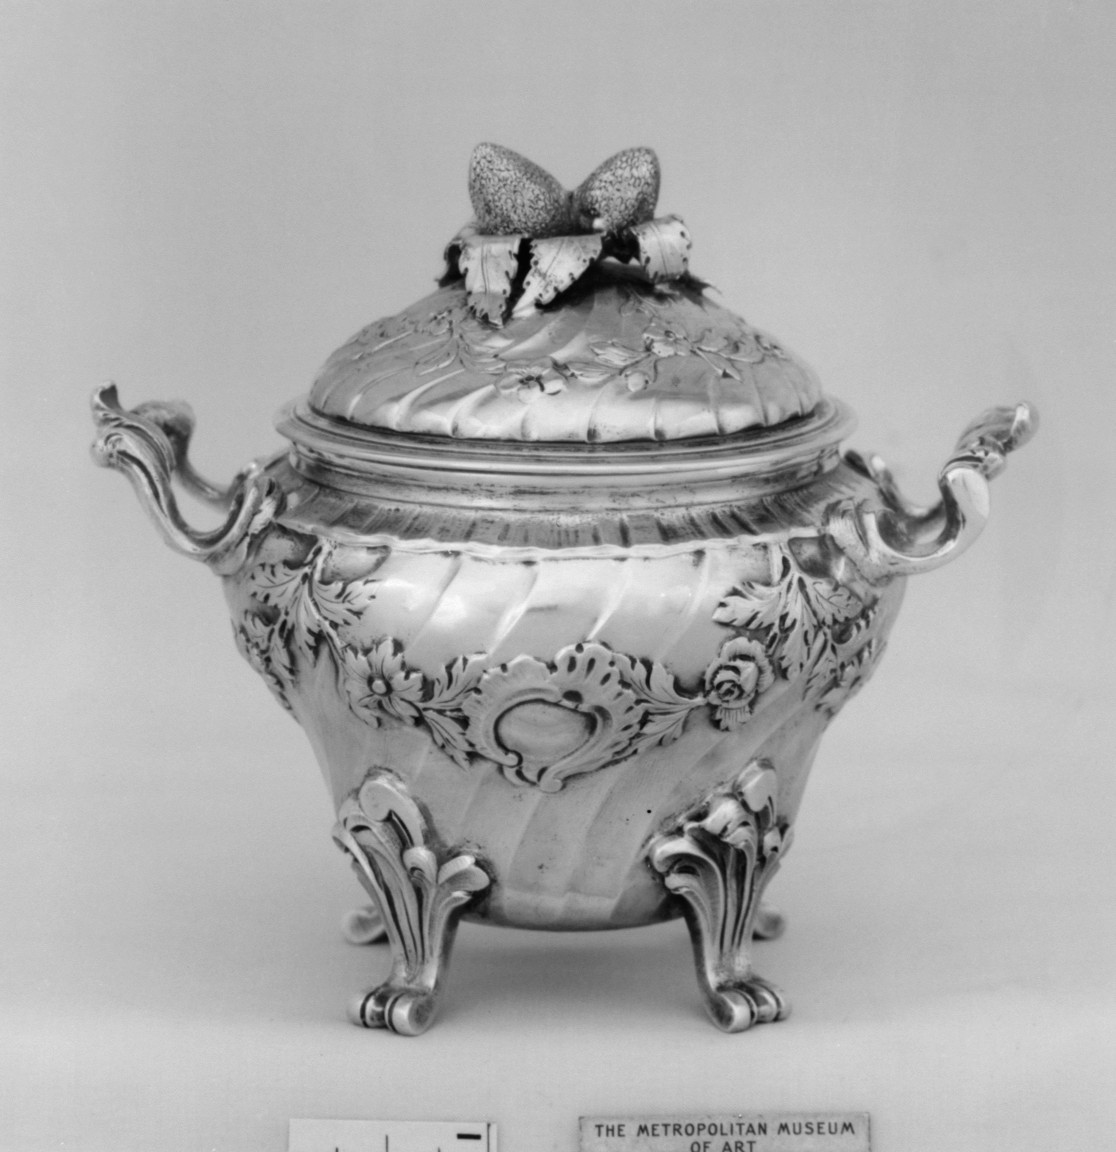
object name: sugar bowl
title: Sugar bowl in 18th century style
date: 1801-1900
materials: silver